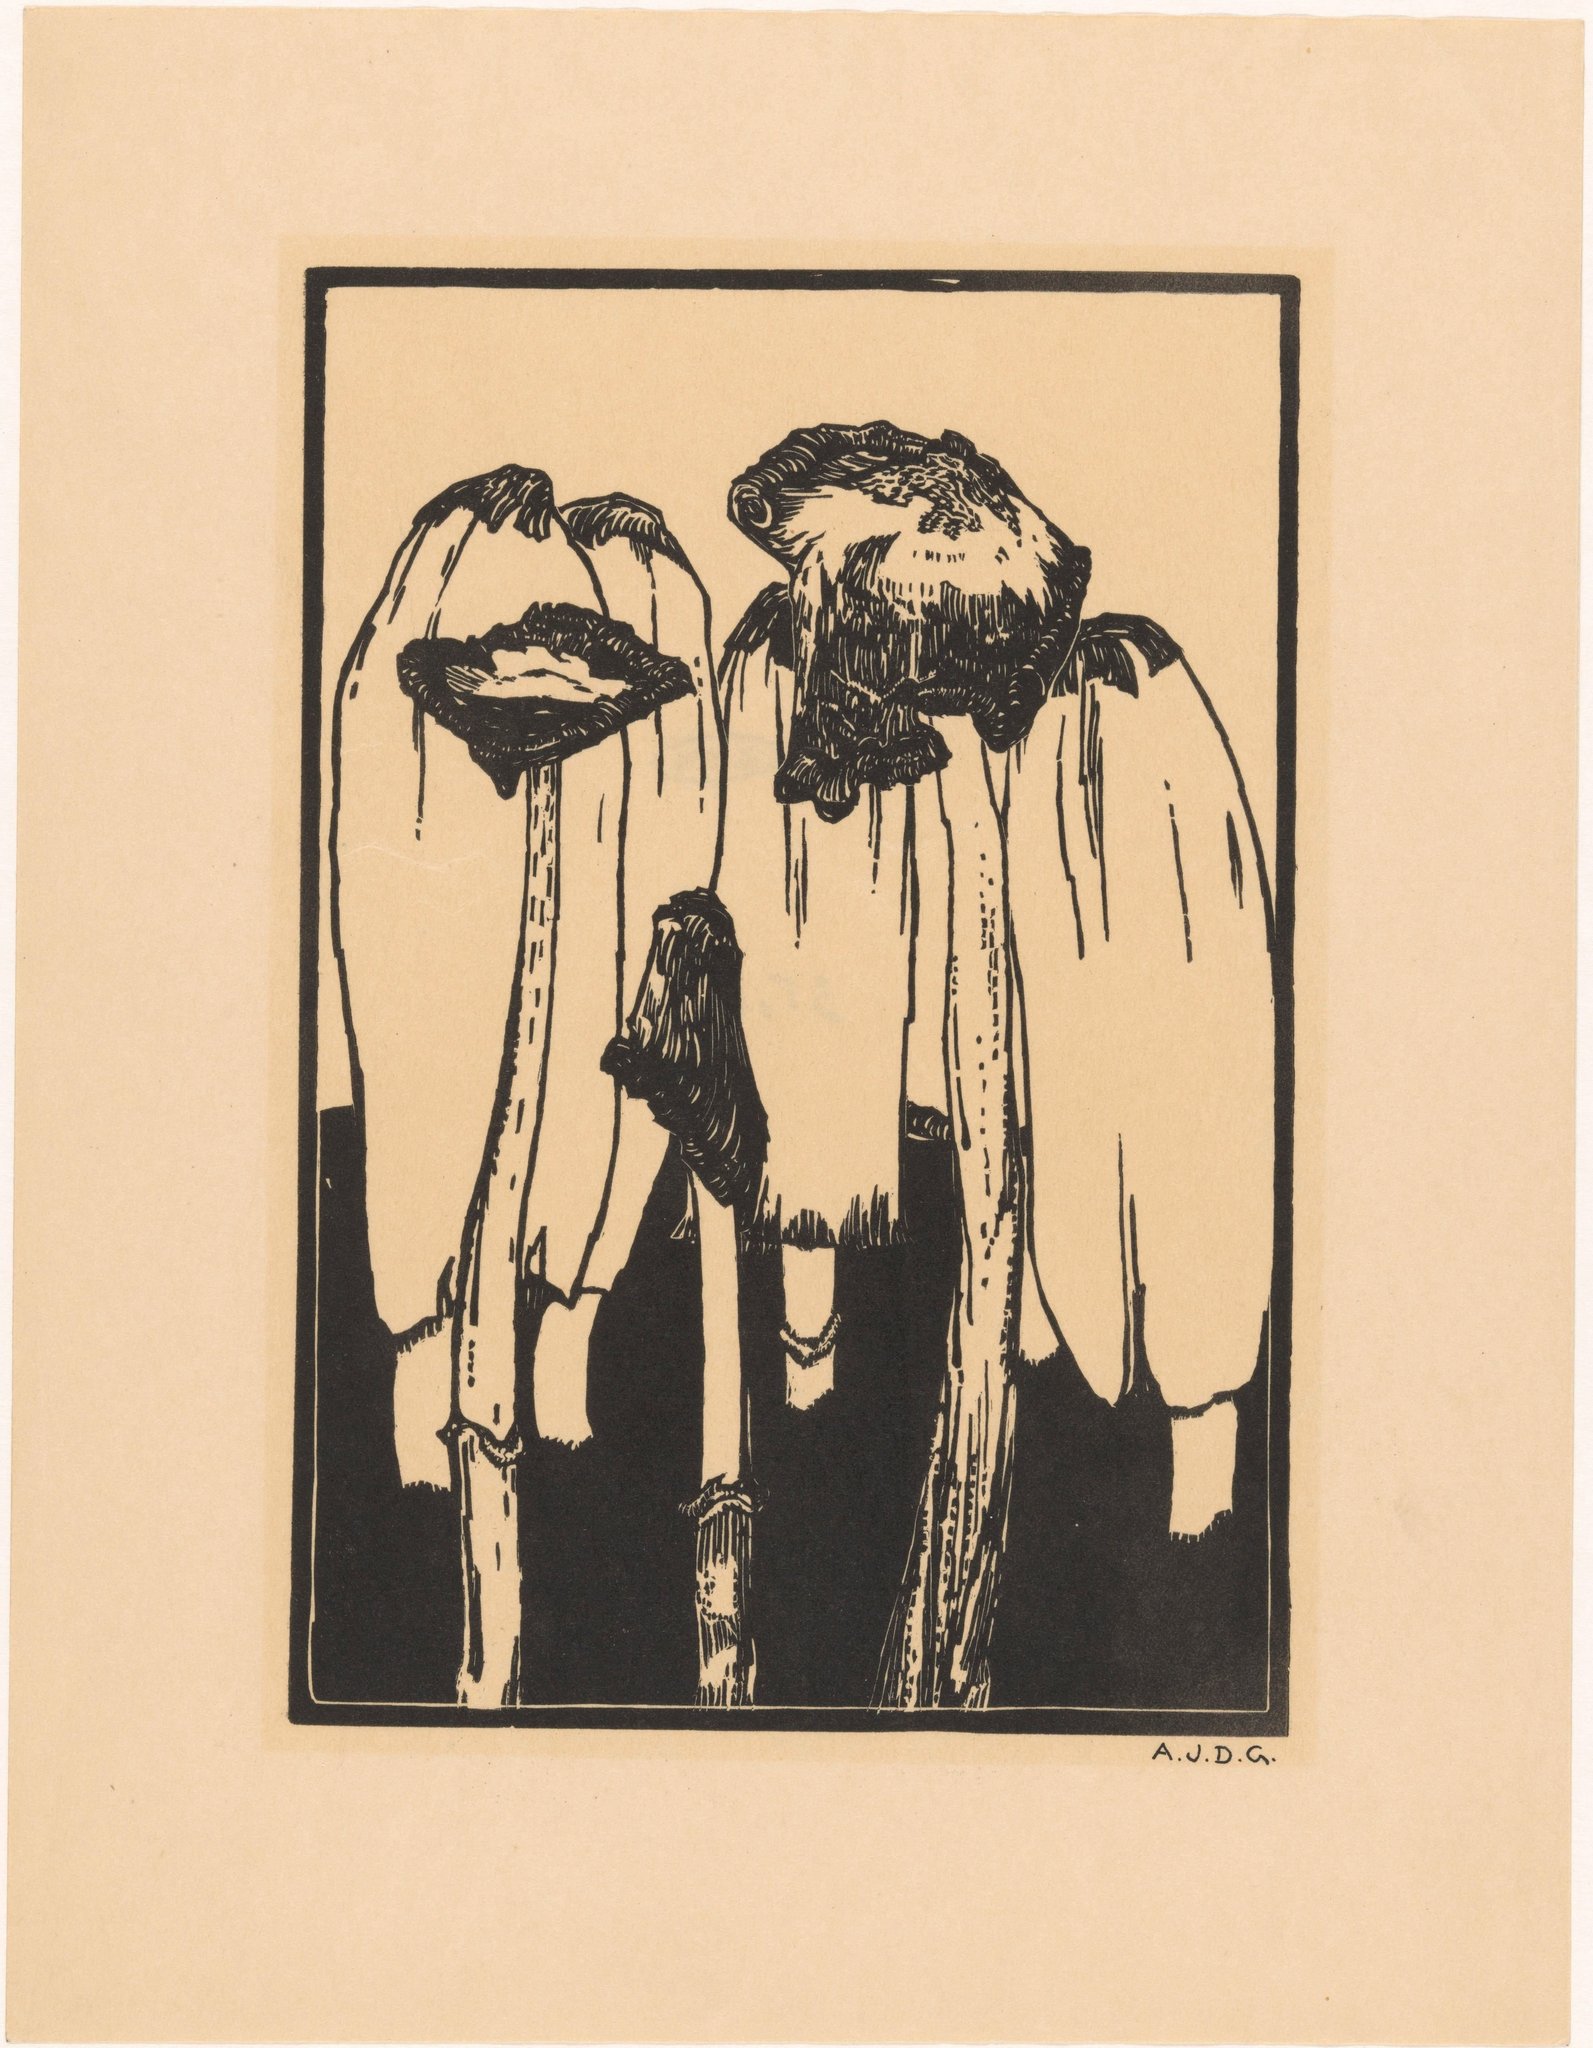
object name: print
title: Inktzwammen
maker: julie de graag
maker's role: draughtsman, print maker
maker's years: 1877-1924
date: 1915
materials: paper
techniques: woodcut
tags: mushrooms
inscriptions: collector's mark: Lugt 2228